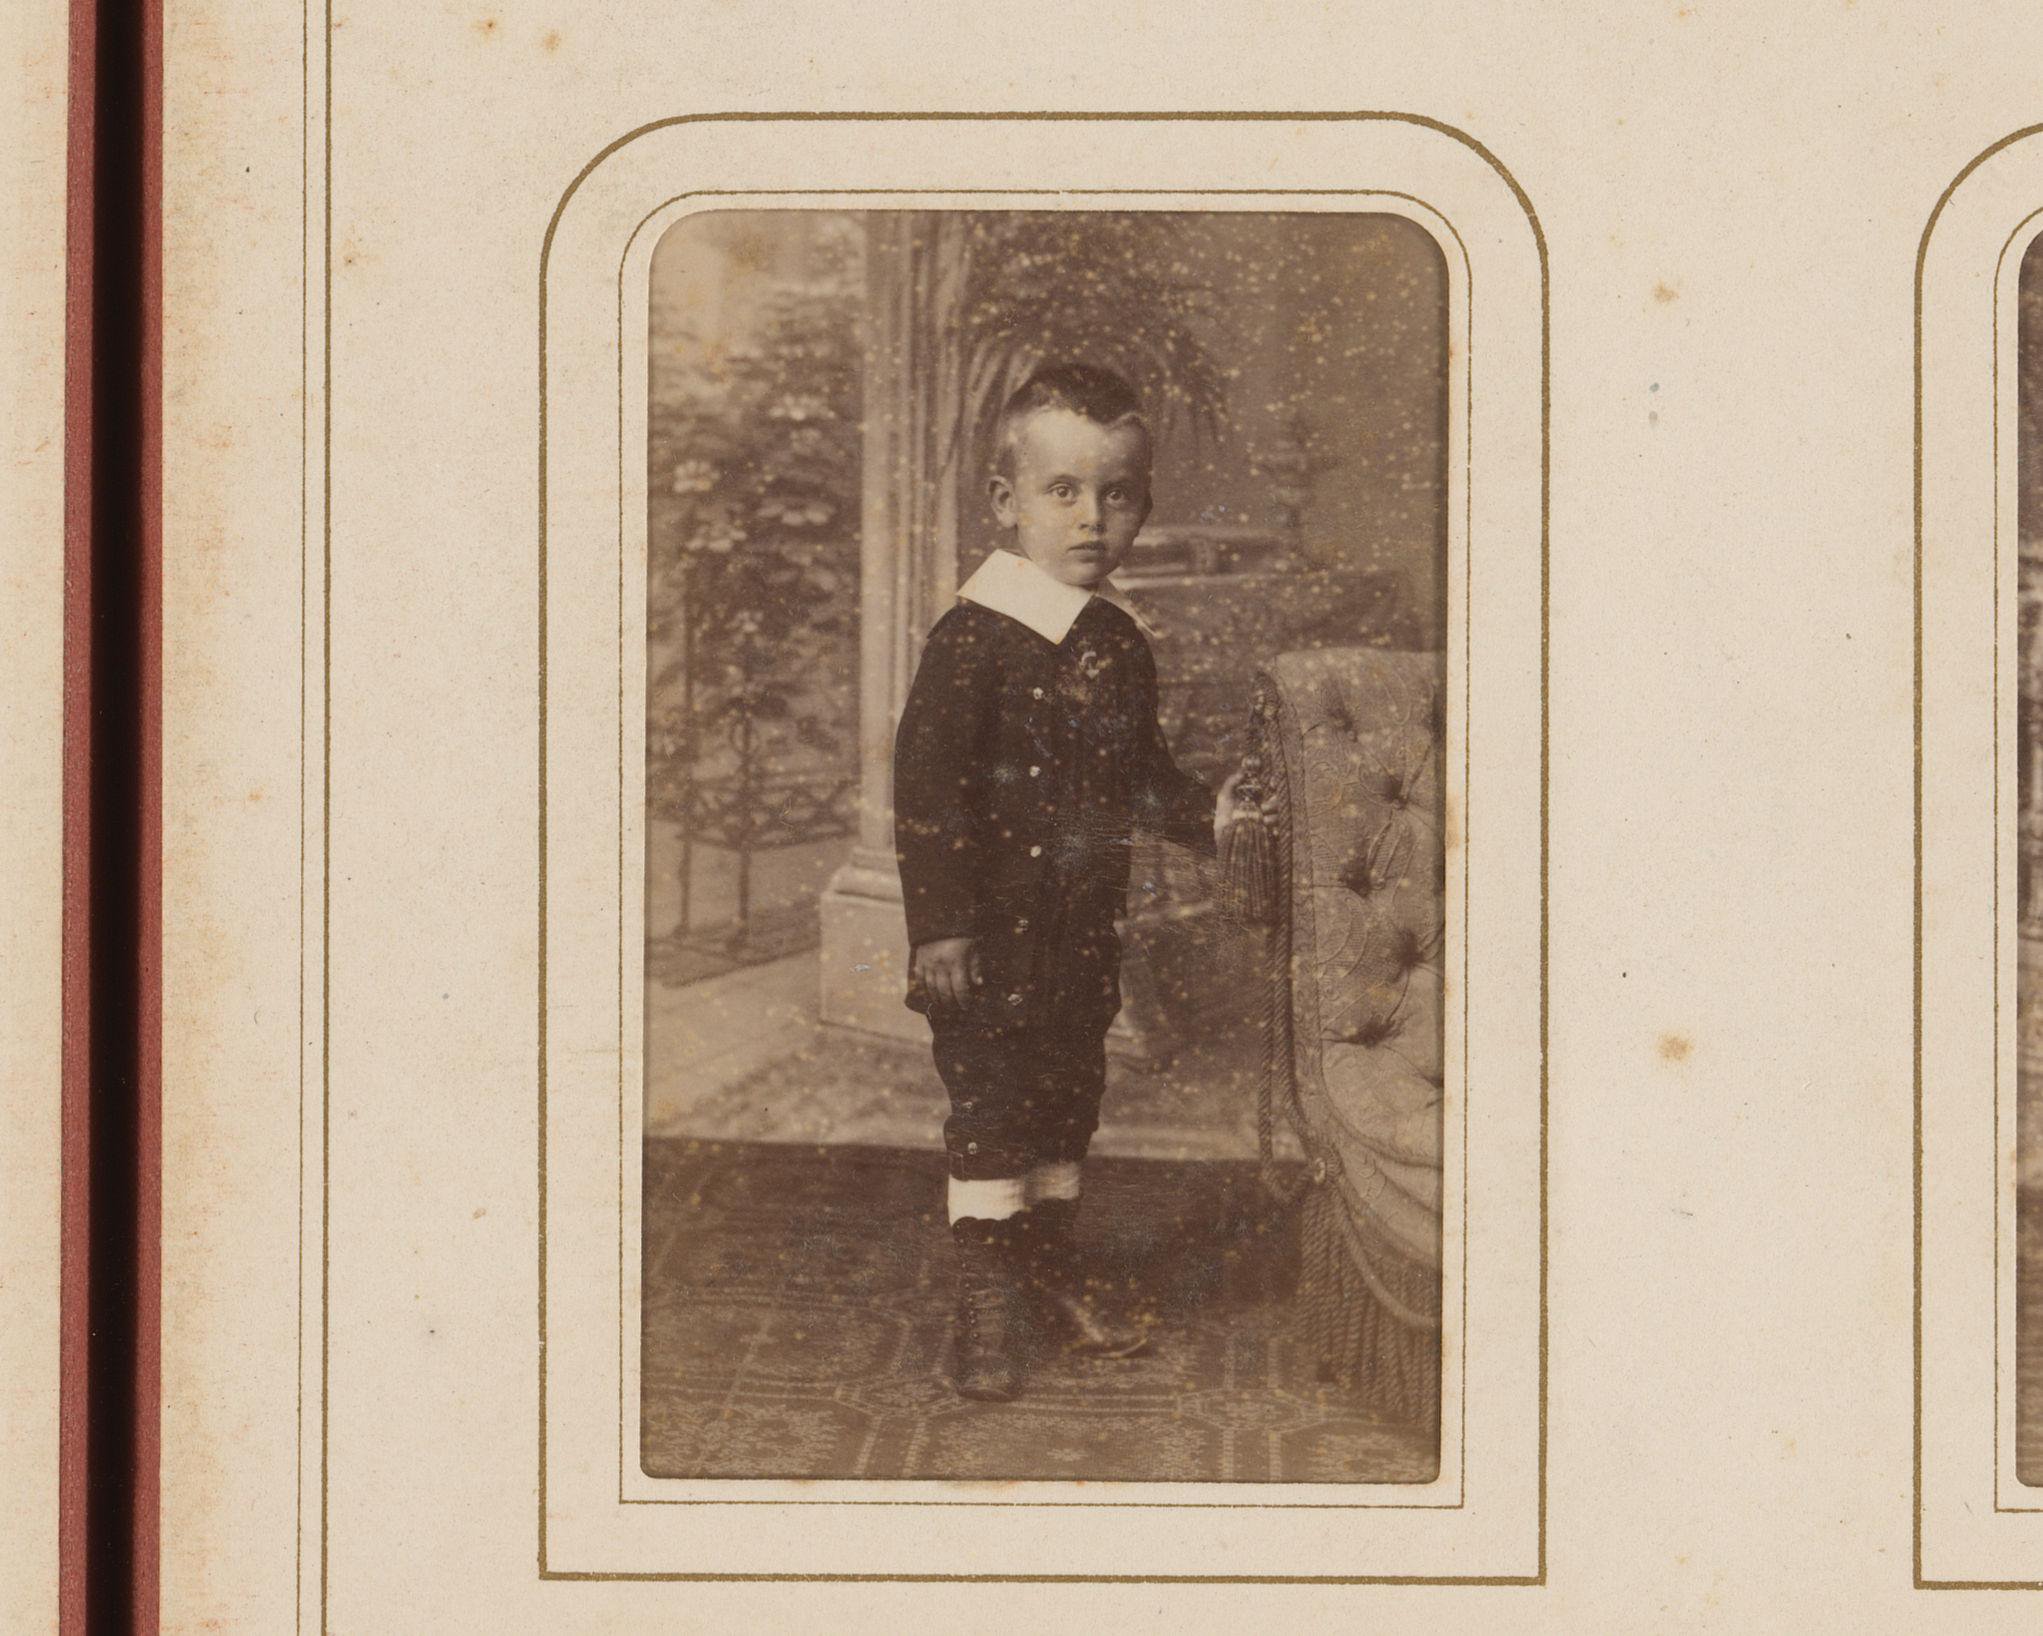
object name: album leaf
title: Portret van een peuter, aangeduid als Carl Hecht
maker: f. salmon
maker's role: fotograaf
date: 1850-1900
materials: cardboard, photographic support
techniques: albumen print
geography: frankenthal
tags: historical persons, toddler (male)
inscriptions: annotation: ‘Carl Hecht/ alt 2. J. 10. M.’, inscription: ‘F. Salmon/ Langes Nachfolger/ FRANKENTHAL/ gegenüber dem/ Bahnhof./ Die Platte bleibt für Nachbestellung aufbewahrt.’